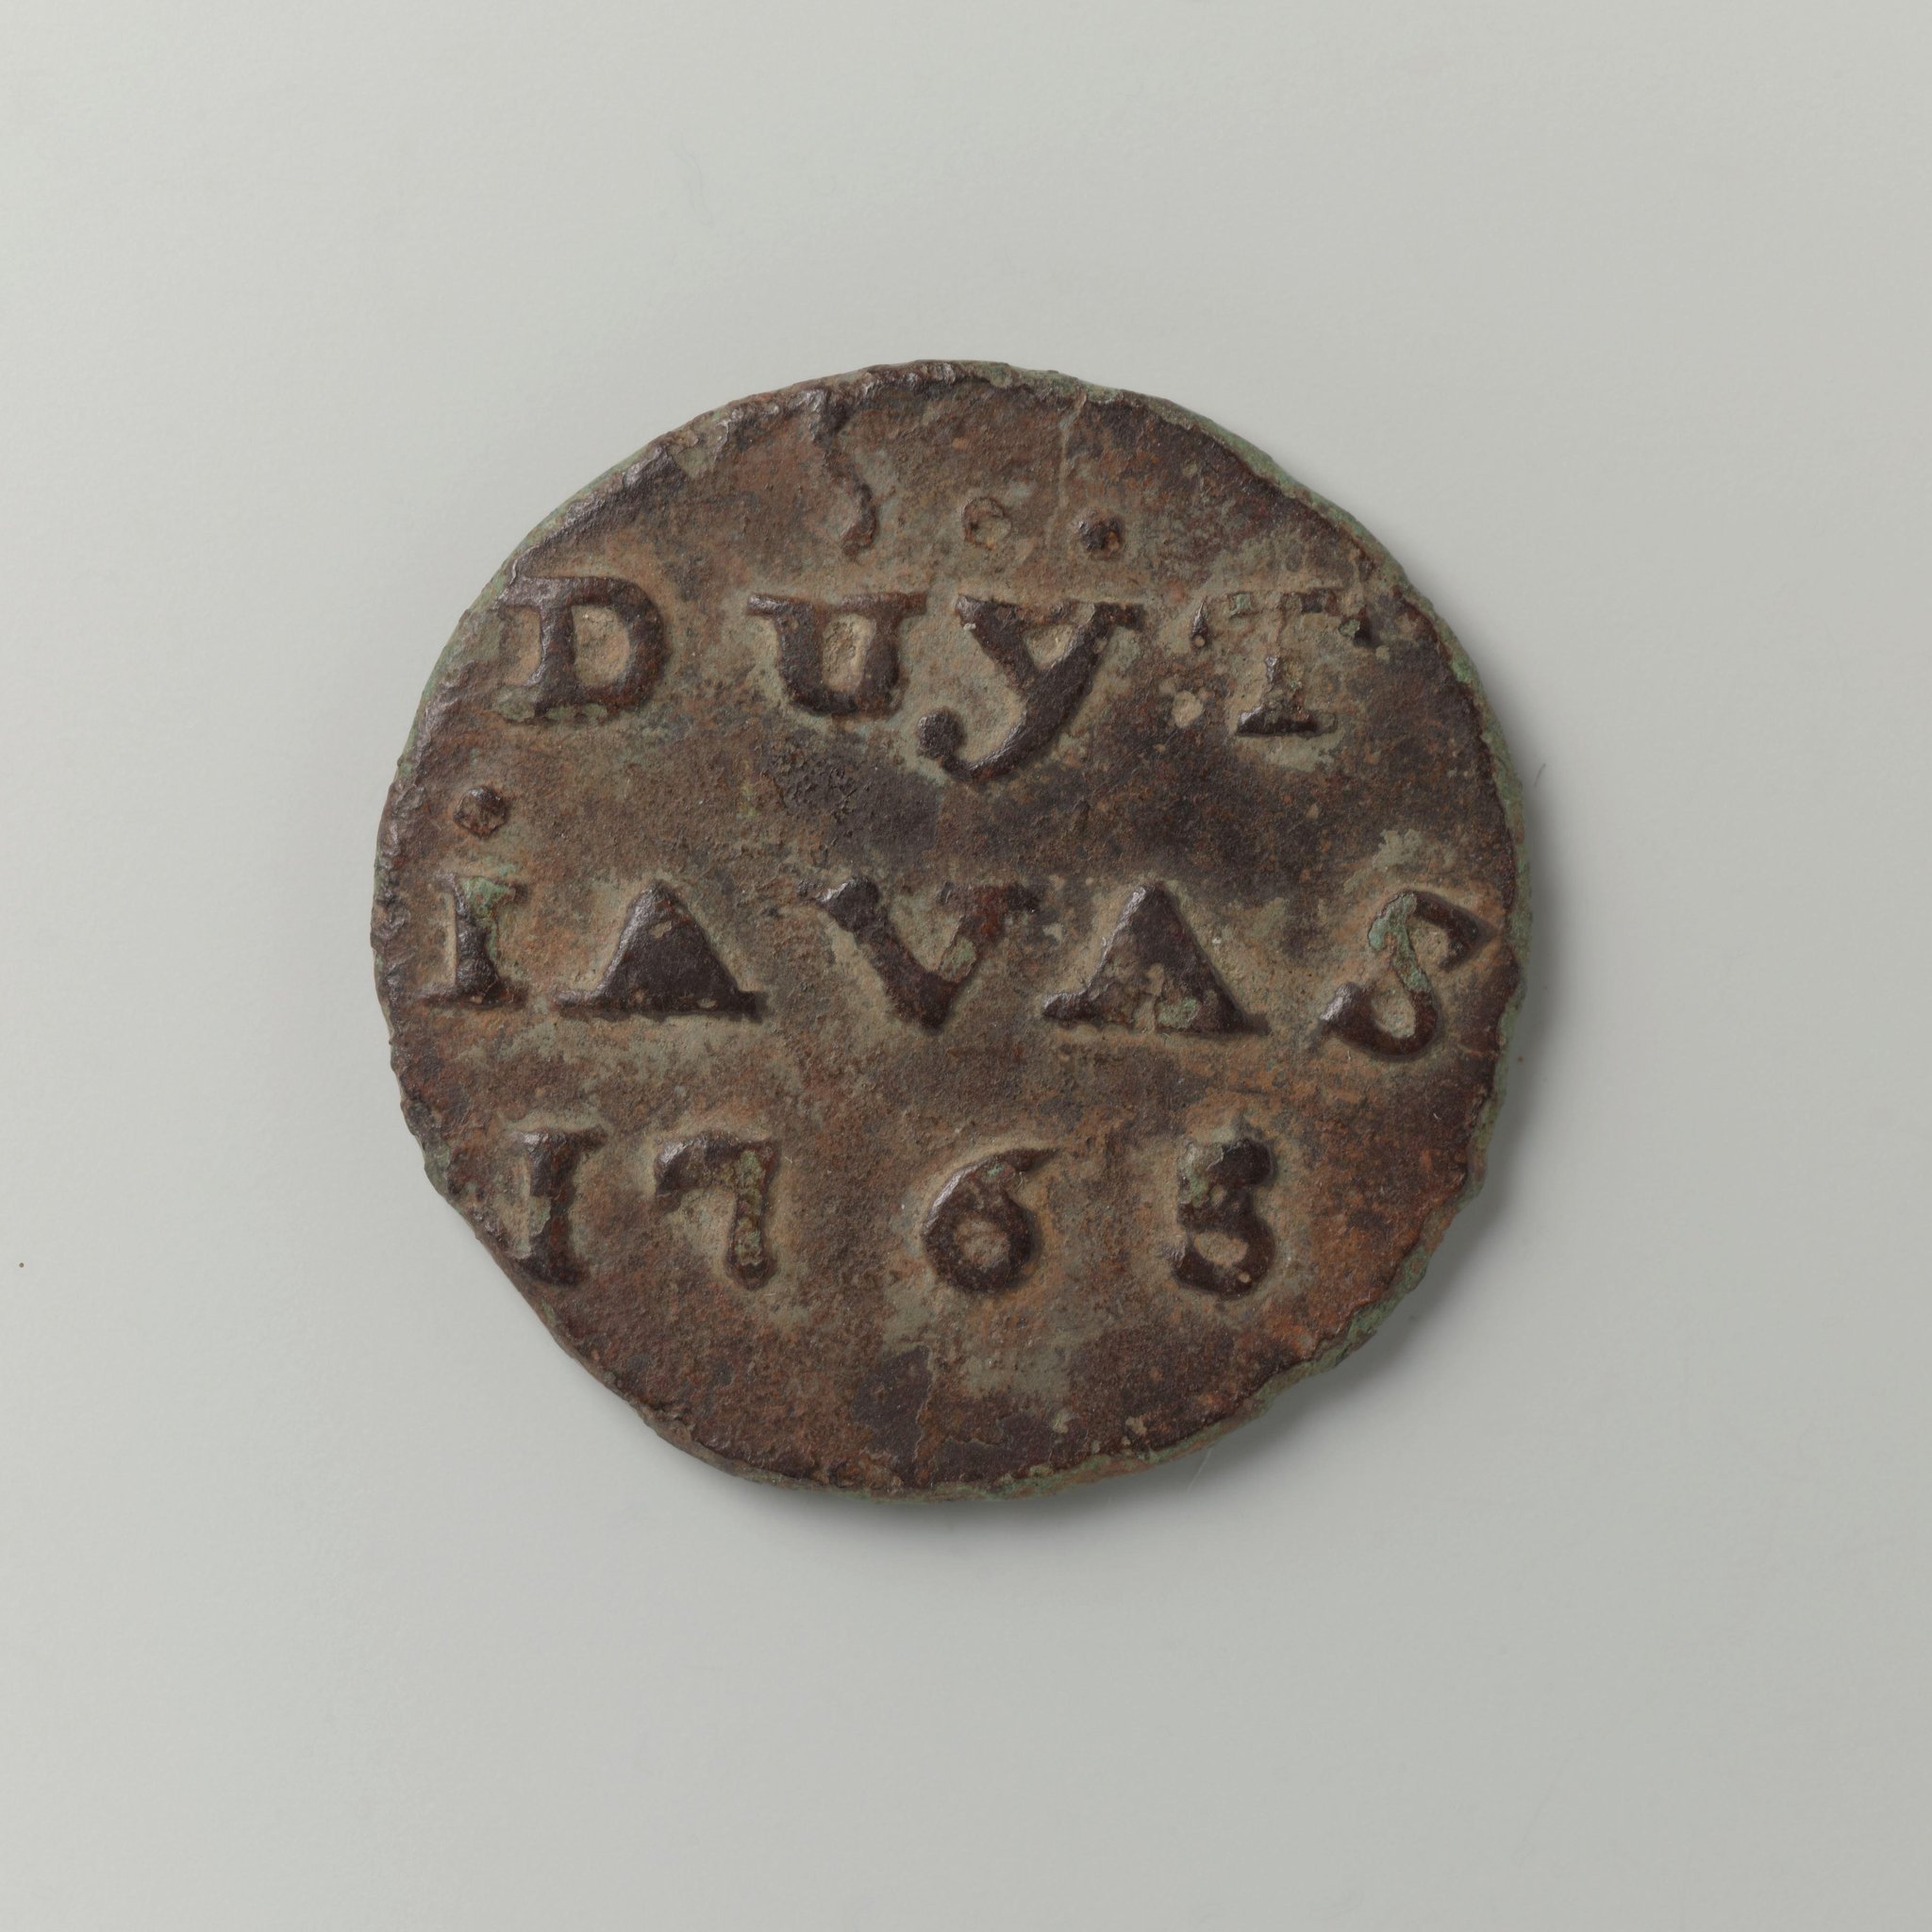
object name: coin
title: Duitvan de VOC uit Java,1765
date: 1765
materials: copper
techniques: striking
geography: batavia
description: Koperen munt. Voorzijde: tweeregelig opschrift in Latijnse letters. Daaronder jaartal in aangepaste Arabische cijfers. Keerzijde: Eensluidend tweeregelig opschrift in Arabische letters. Daaronder jaartal in oorspronkelijke Arabische cijfers. Gladde rand.